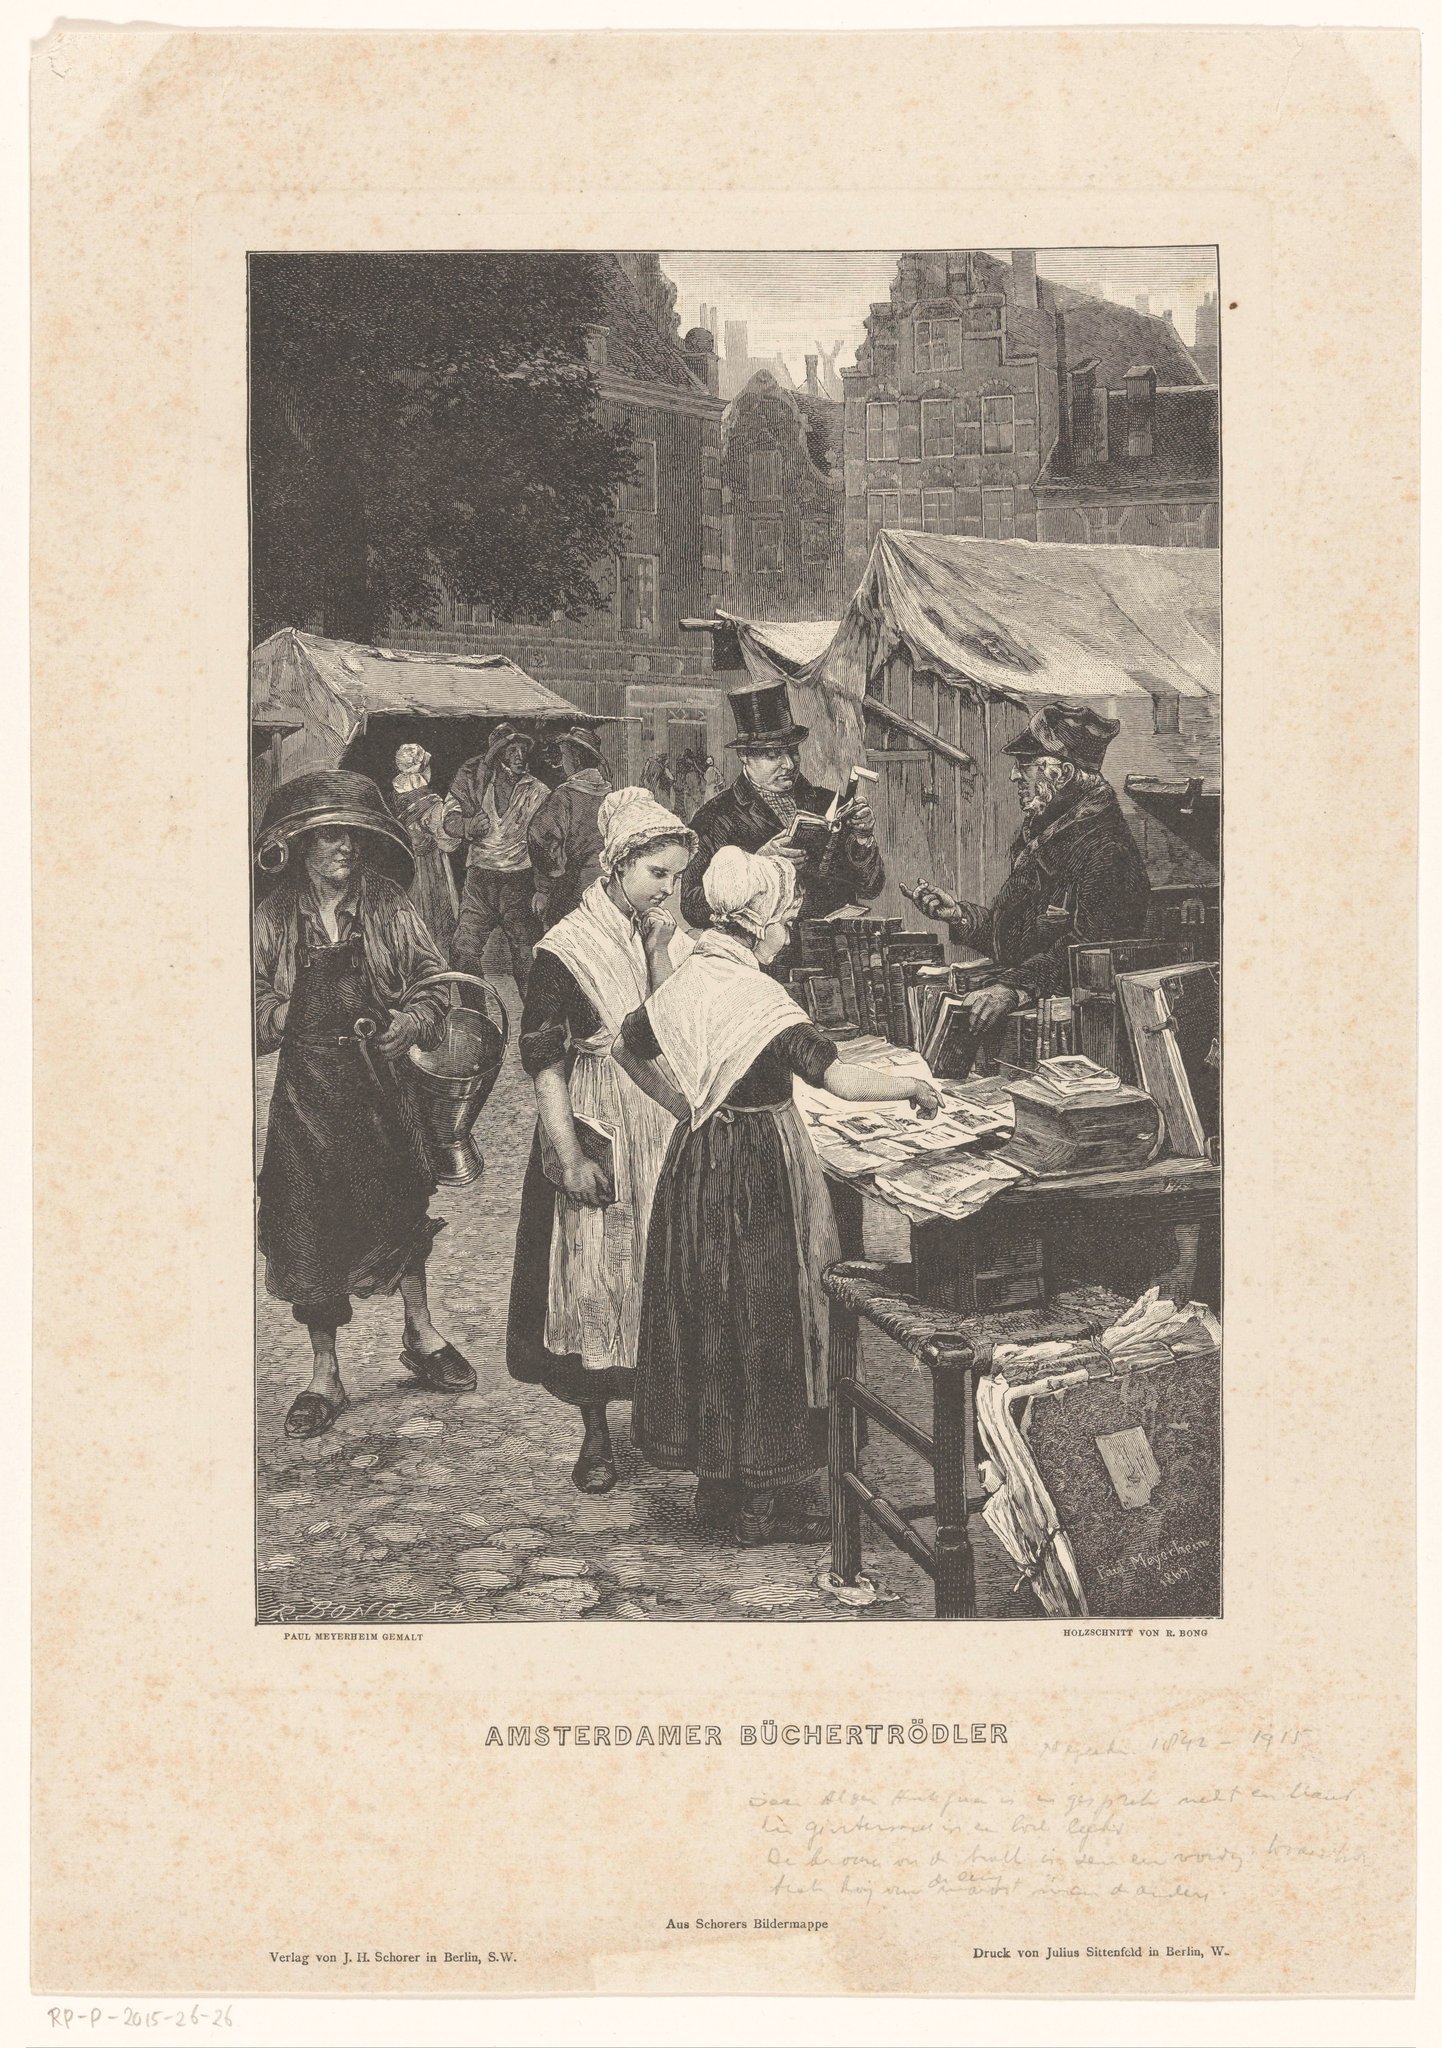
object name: print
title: Amsterdamer Büchtrödler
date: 1880-1894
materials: paper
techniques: letterpress printing, engraving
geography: berlin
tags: book-stall, kiosk, orphans, city-view in general; 'veduta' (+ city(-scape) with figures, staffage), amsterdam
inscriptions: collector's mark: Lugt 2228, collector's mark: Lugt 4780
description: Prent afkomstig uit: Schorers Bildermappe, behorende bij het Deutsches Familienblatt [voorgezet als: Schorers Familienblatt]. Berlijn: J.H. Schorer, 1880-1894.